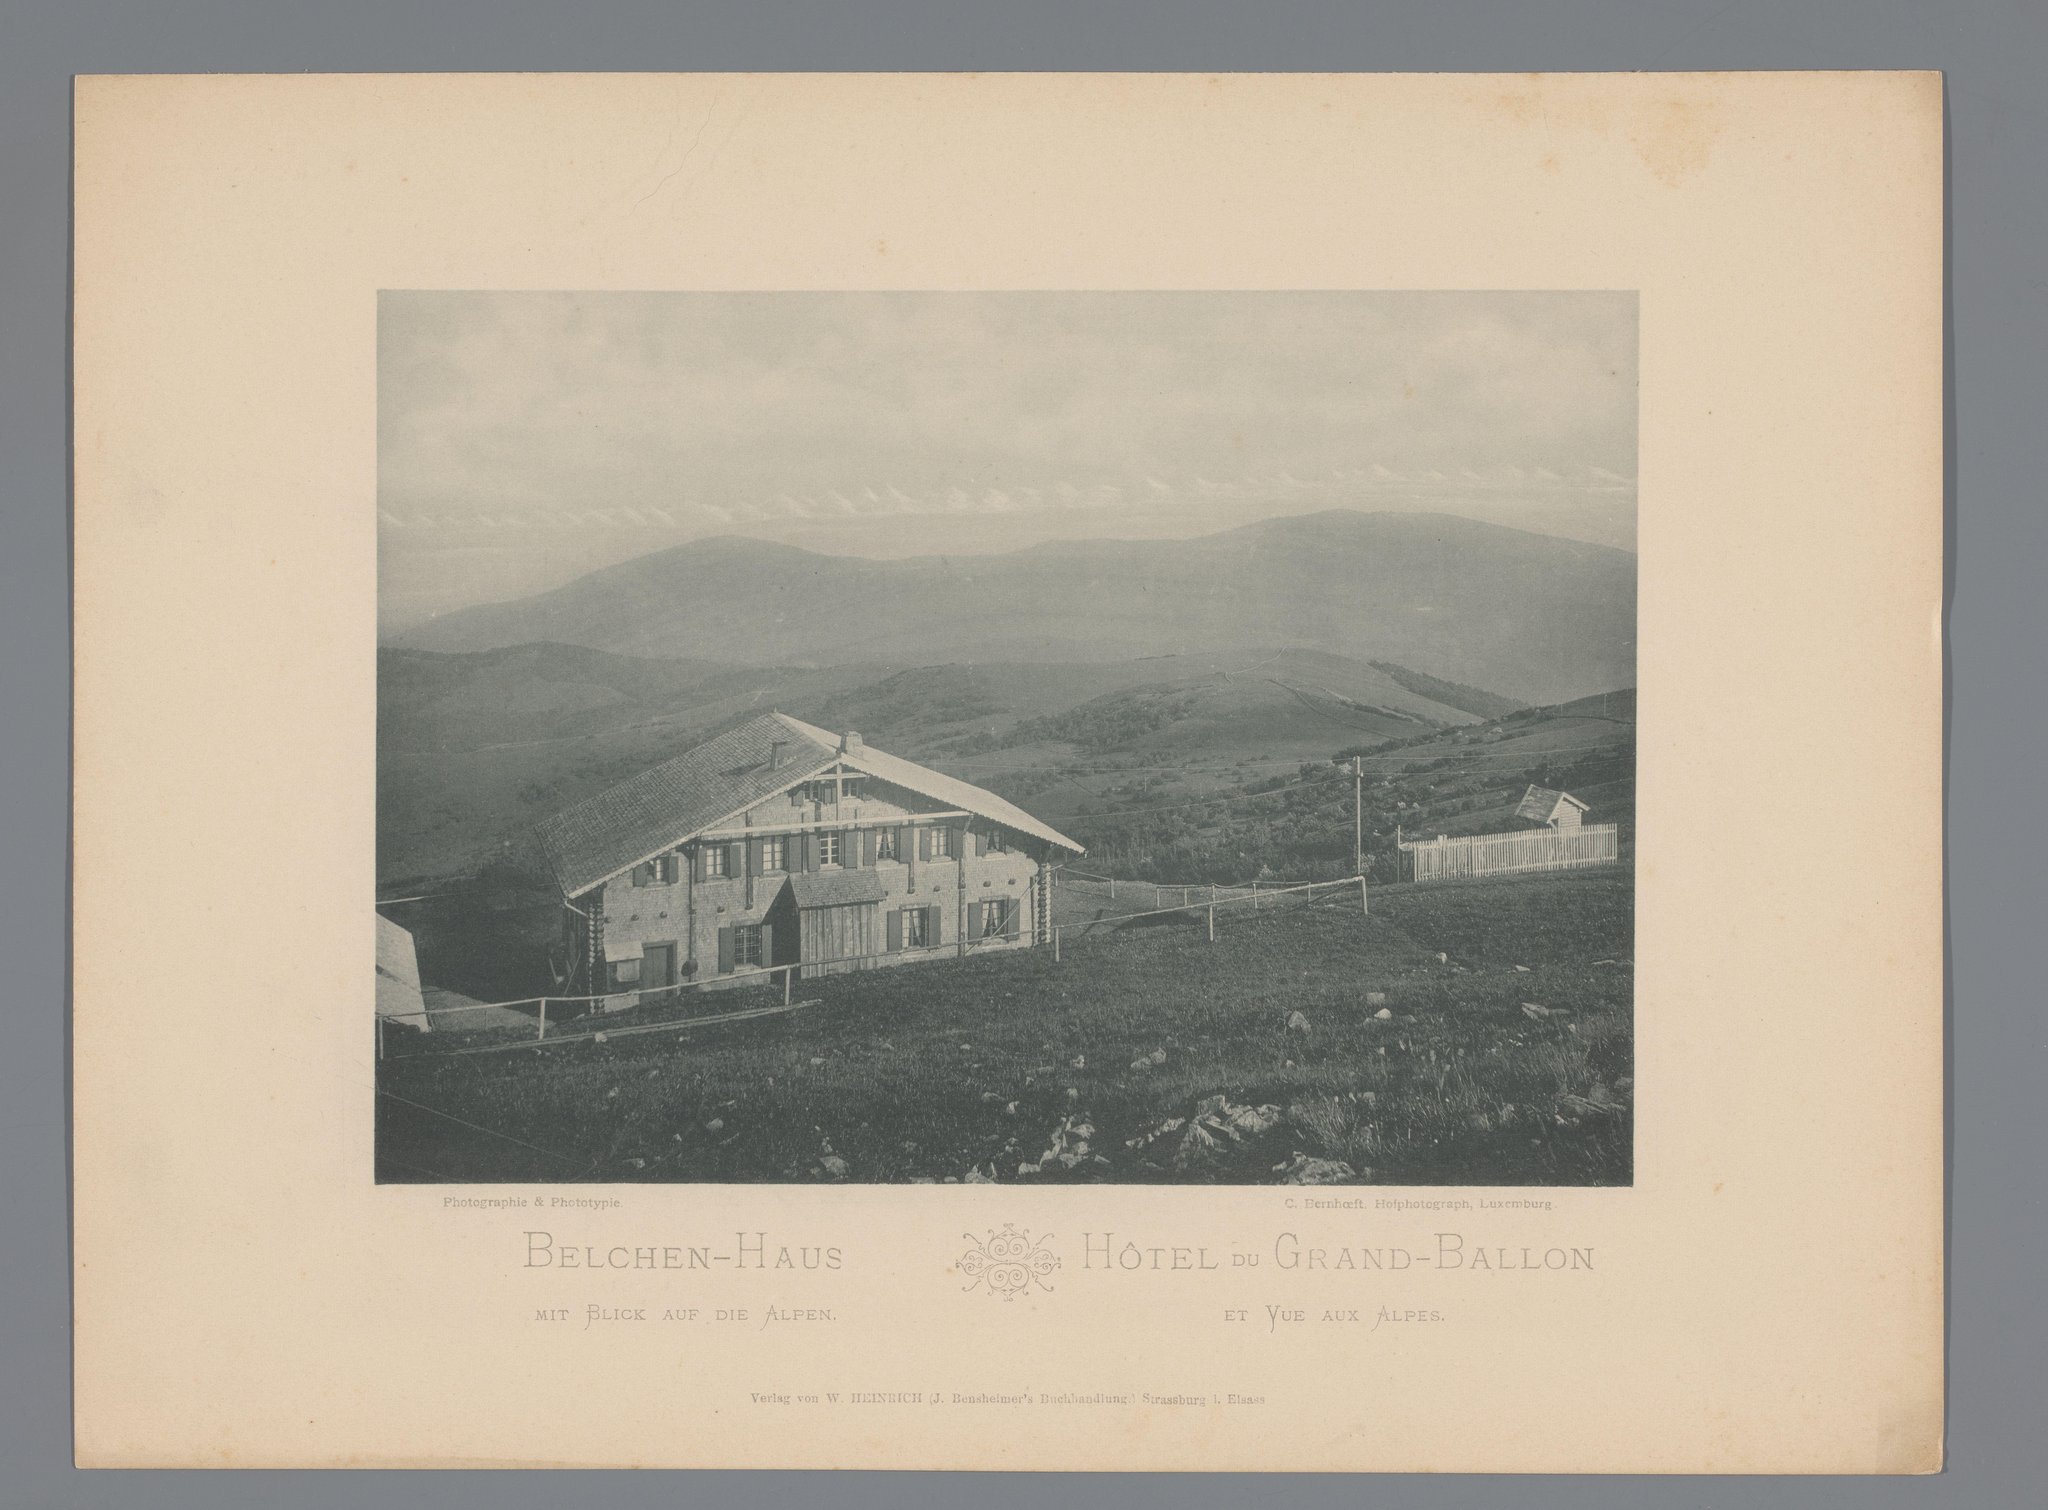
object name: photomechanical print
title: Gezicht op een hotel op de Grand Ballon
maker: charles bernhoeft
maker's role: publisher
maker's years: 1859-1933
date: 1889-1894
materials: paper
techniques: photograph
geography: luxembourg city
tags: hotel, hostelry, inn, mountains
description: Deze prent maakt deel uit van een omslag met 100 prenten.